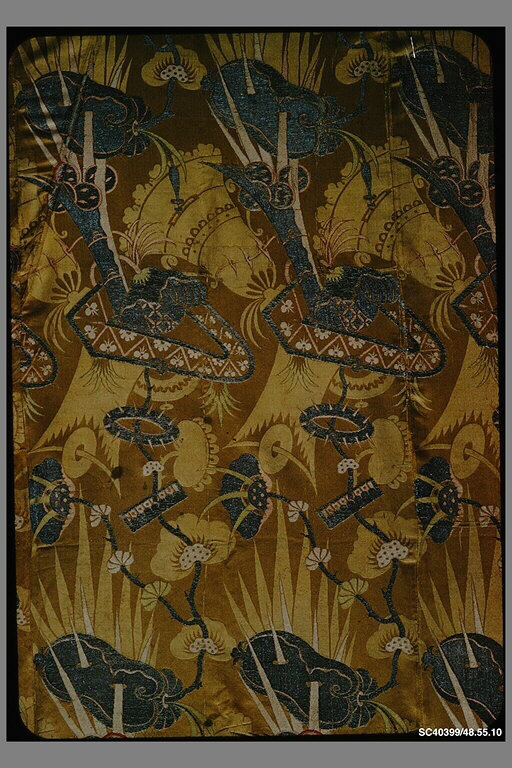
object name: panel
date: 1701-1750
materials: metal thread, silk